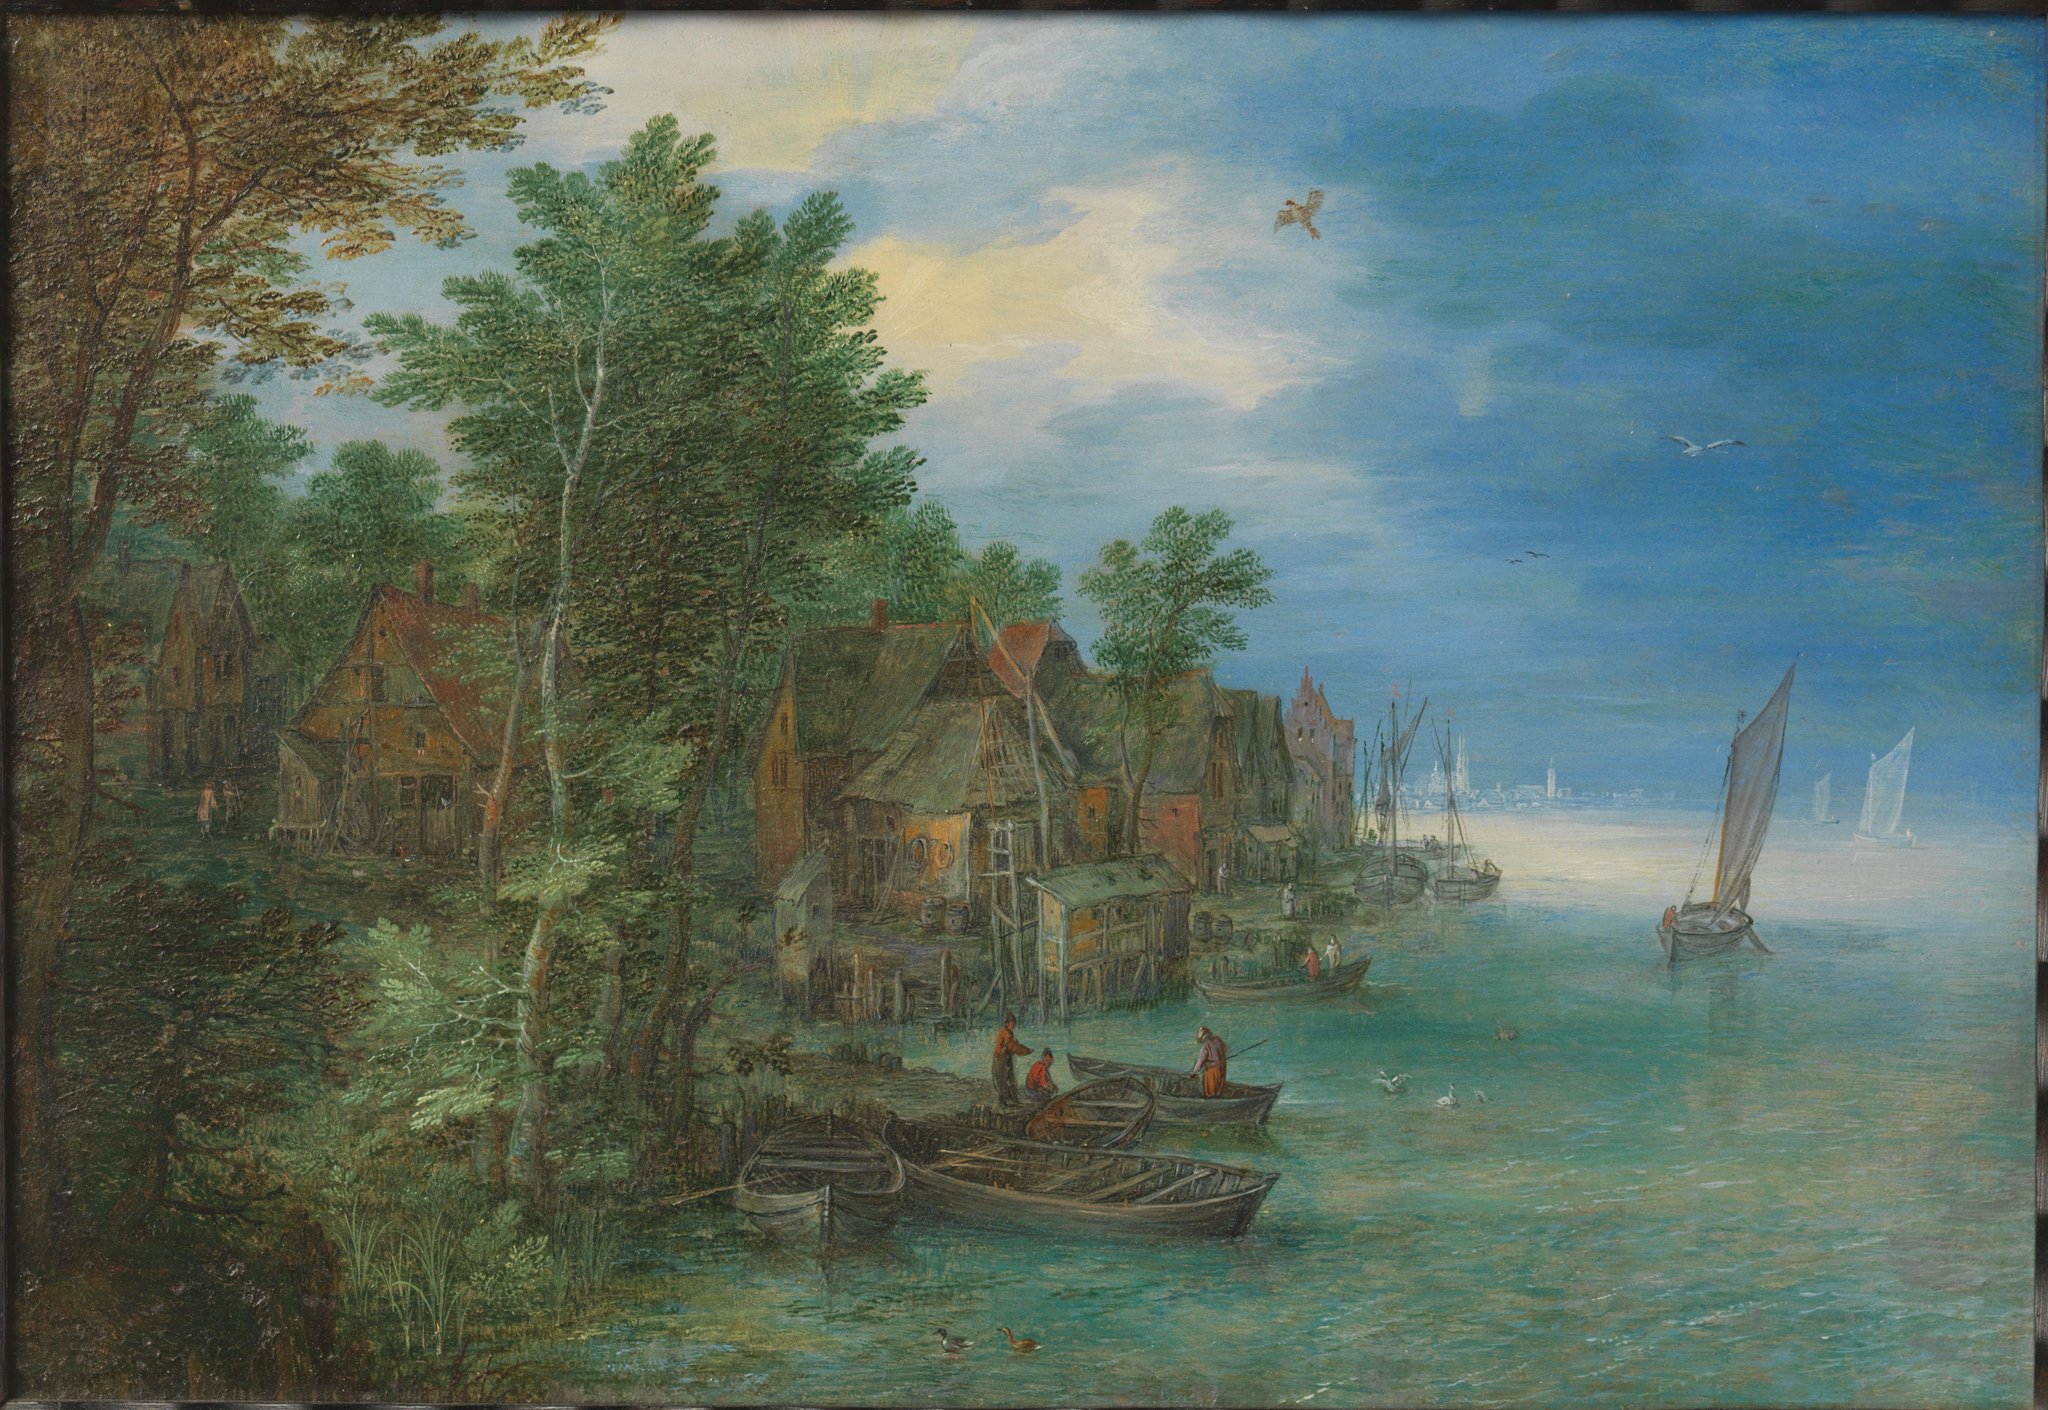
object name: painting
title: View of a Village on a River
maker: jan brueghel (i)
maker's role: draughtsman, painter, print maker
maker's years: 1568-1625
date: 1604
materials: copper, oil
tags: sailing-ship, sailing-boat, river, village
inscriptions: signature and date: ‘Brveghel 1604’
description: The workshop of Jan Brueghel I must have been a successful, well-run business. In addition to large paintings made on commission, it roduced an endless stream of landscapes for the free market. These small paintings were variations on a limited range of models. This landscape is a well preserved, finely executed – and probably autograph – example.